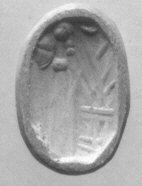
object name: stamp seal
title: Stamp seal (octagonal pyramid) with cultic scene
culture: assyro-babylonian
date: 700-501 BCE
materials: stone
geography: mesopotamia